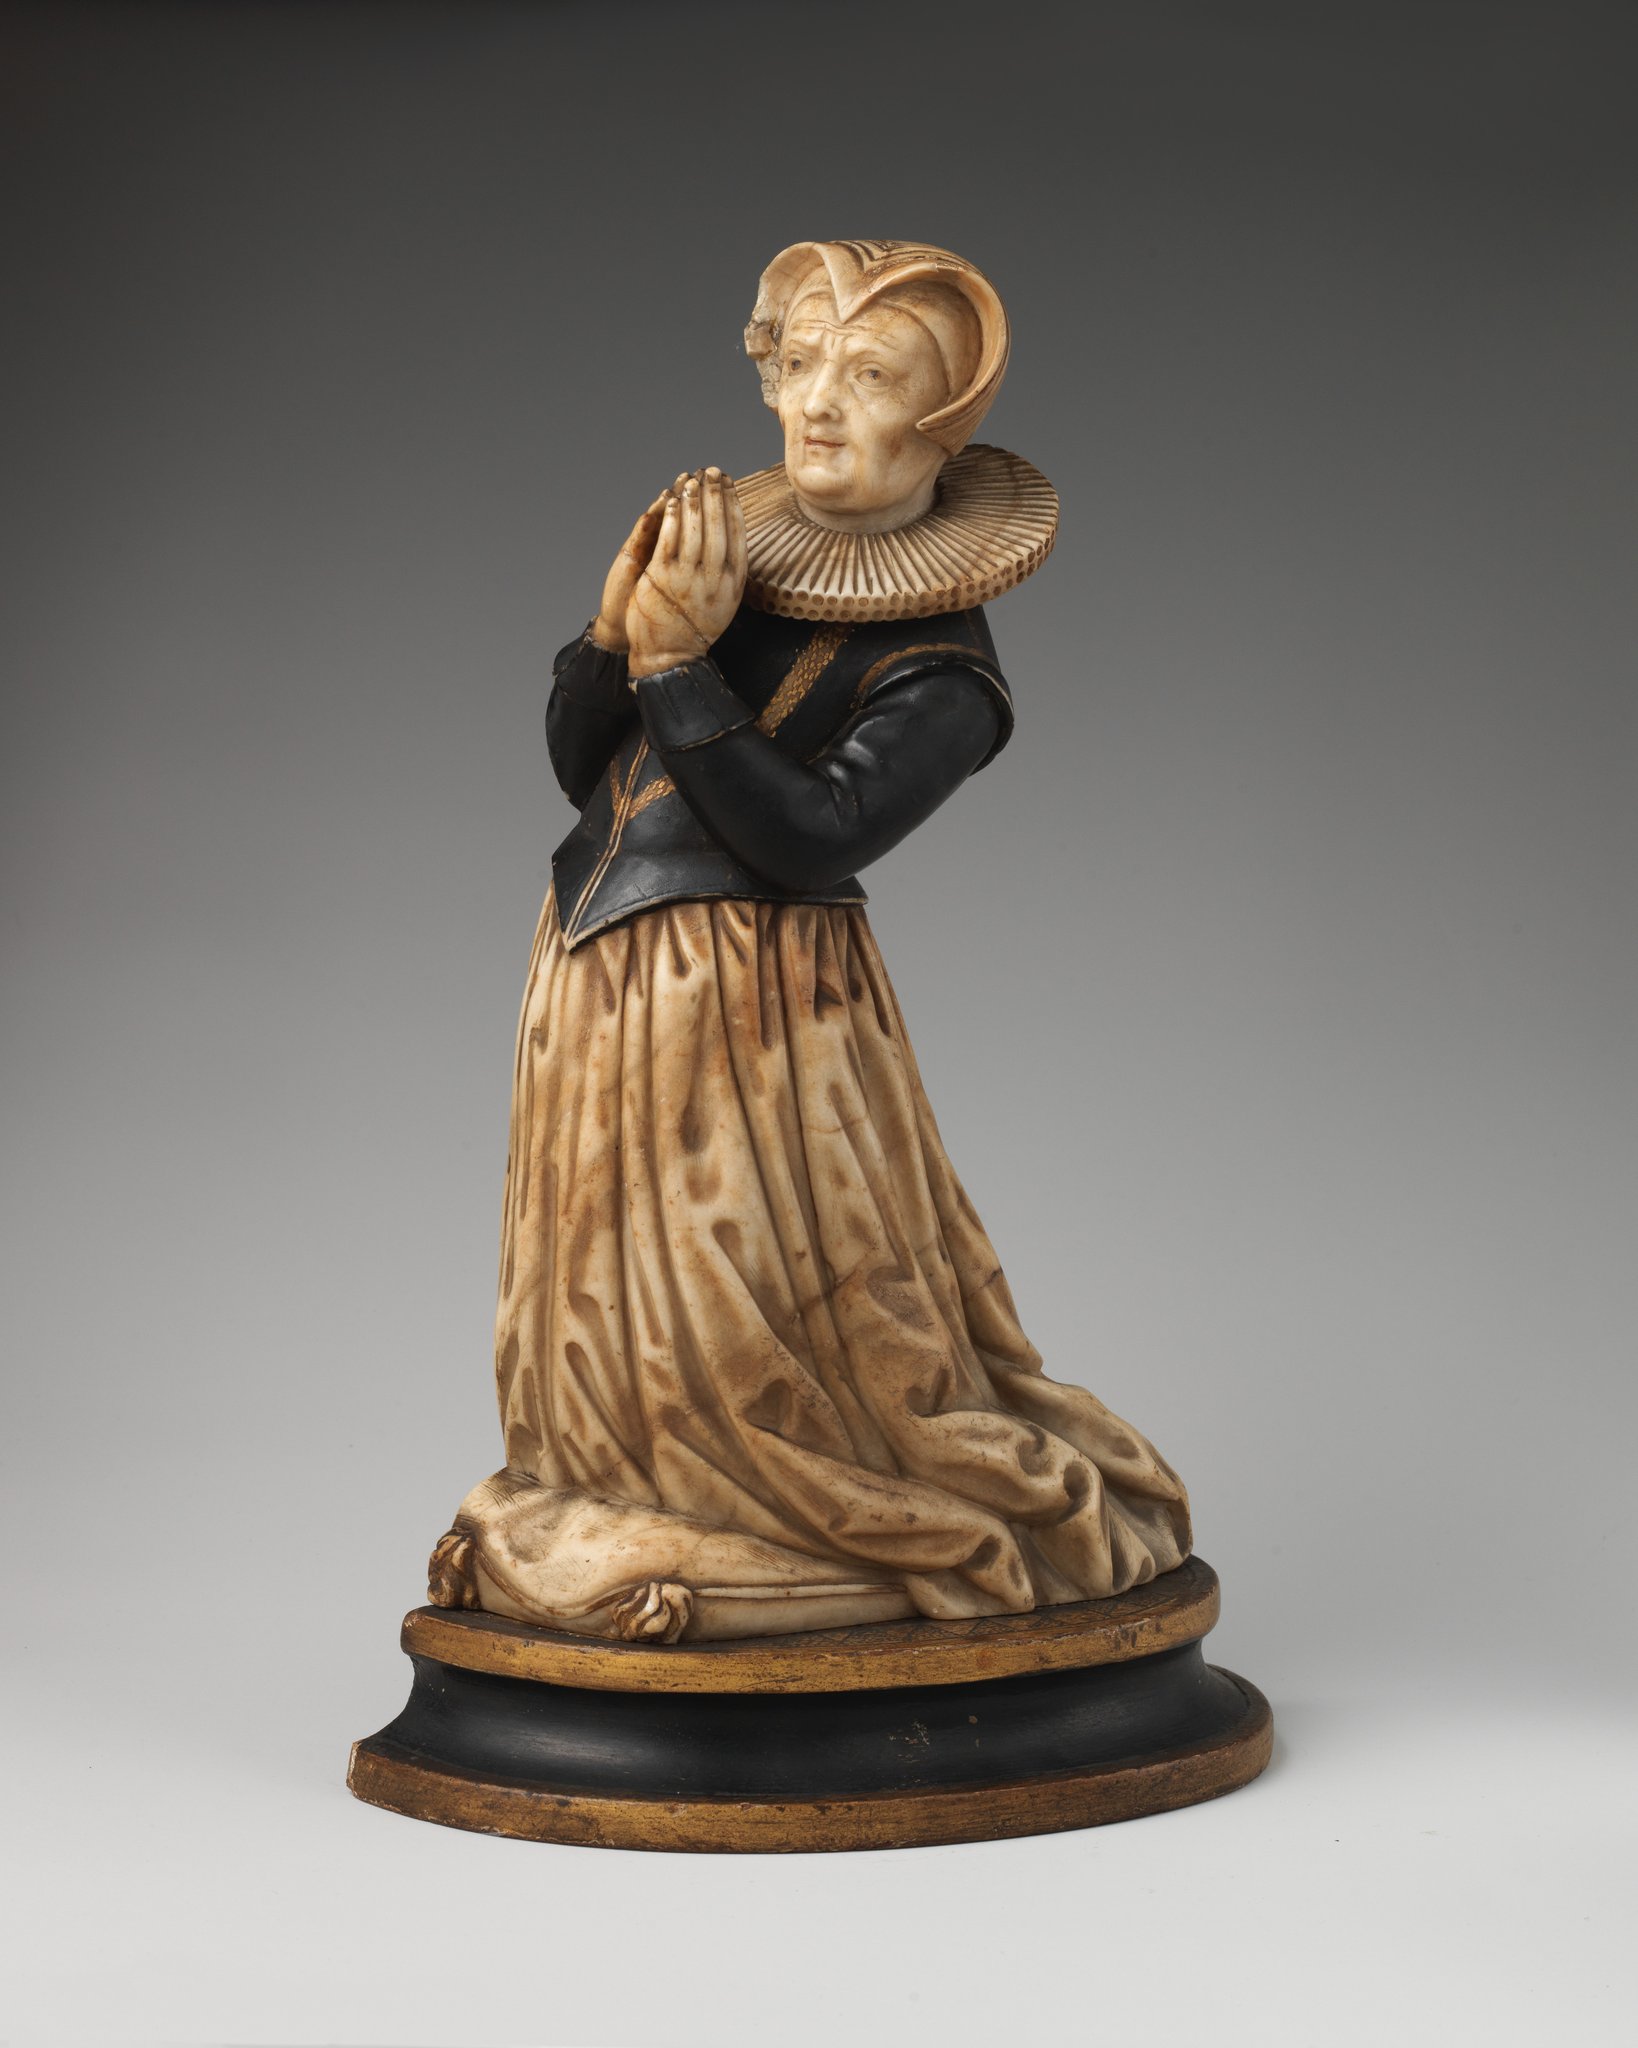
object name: statuette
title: Kneeling woman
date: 1600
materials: alabaster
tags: women